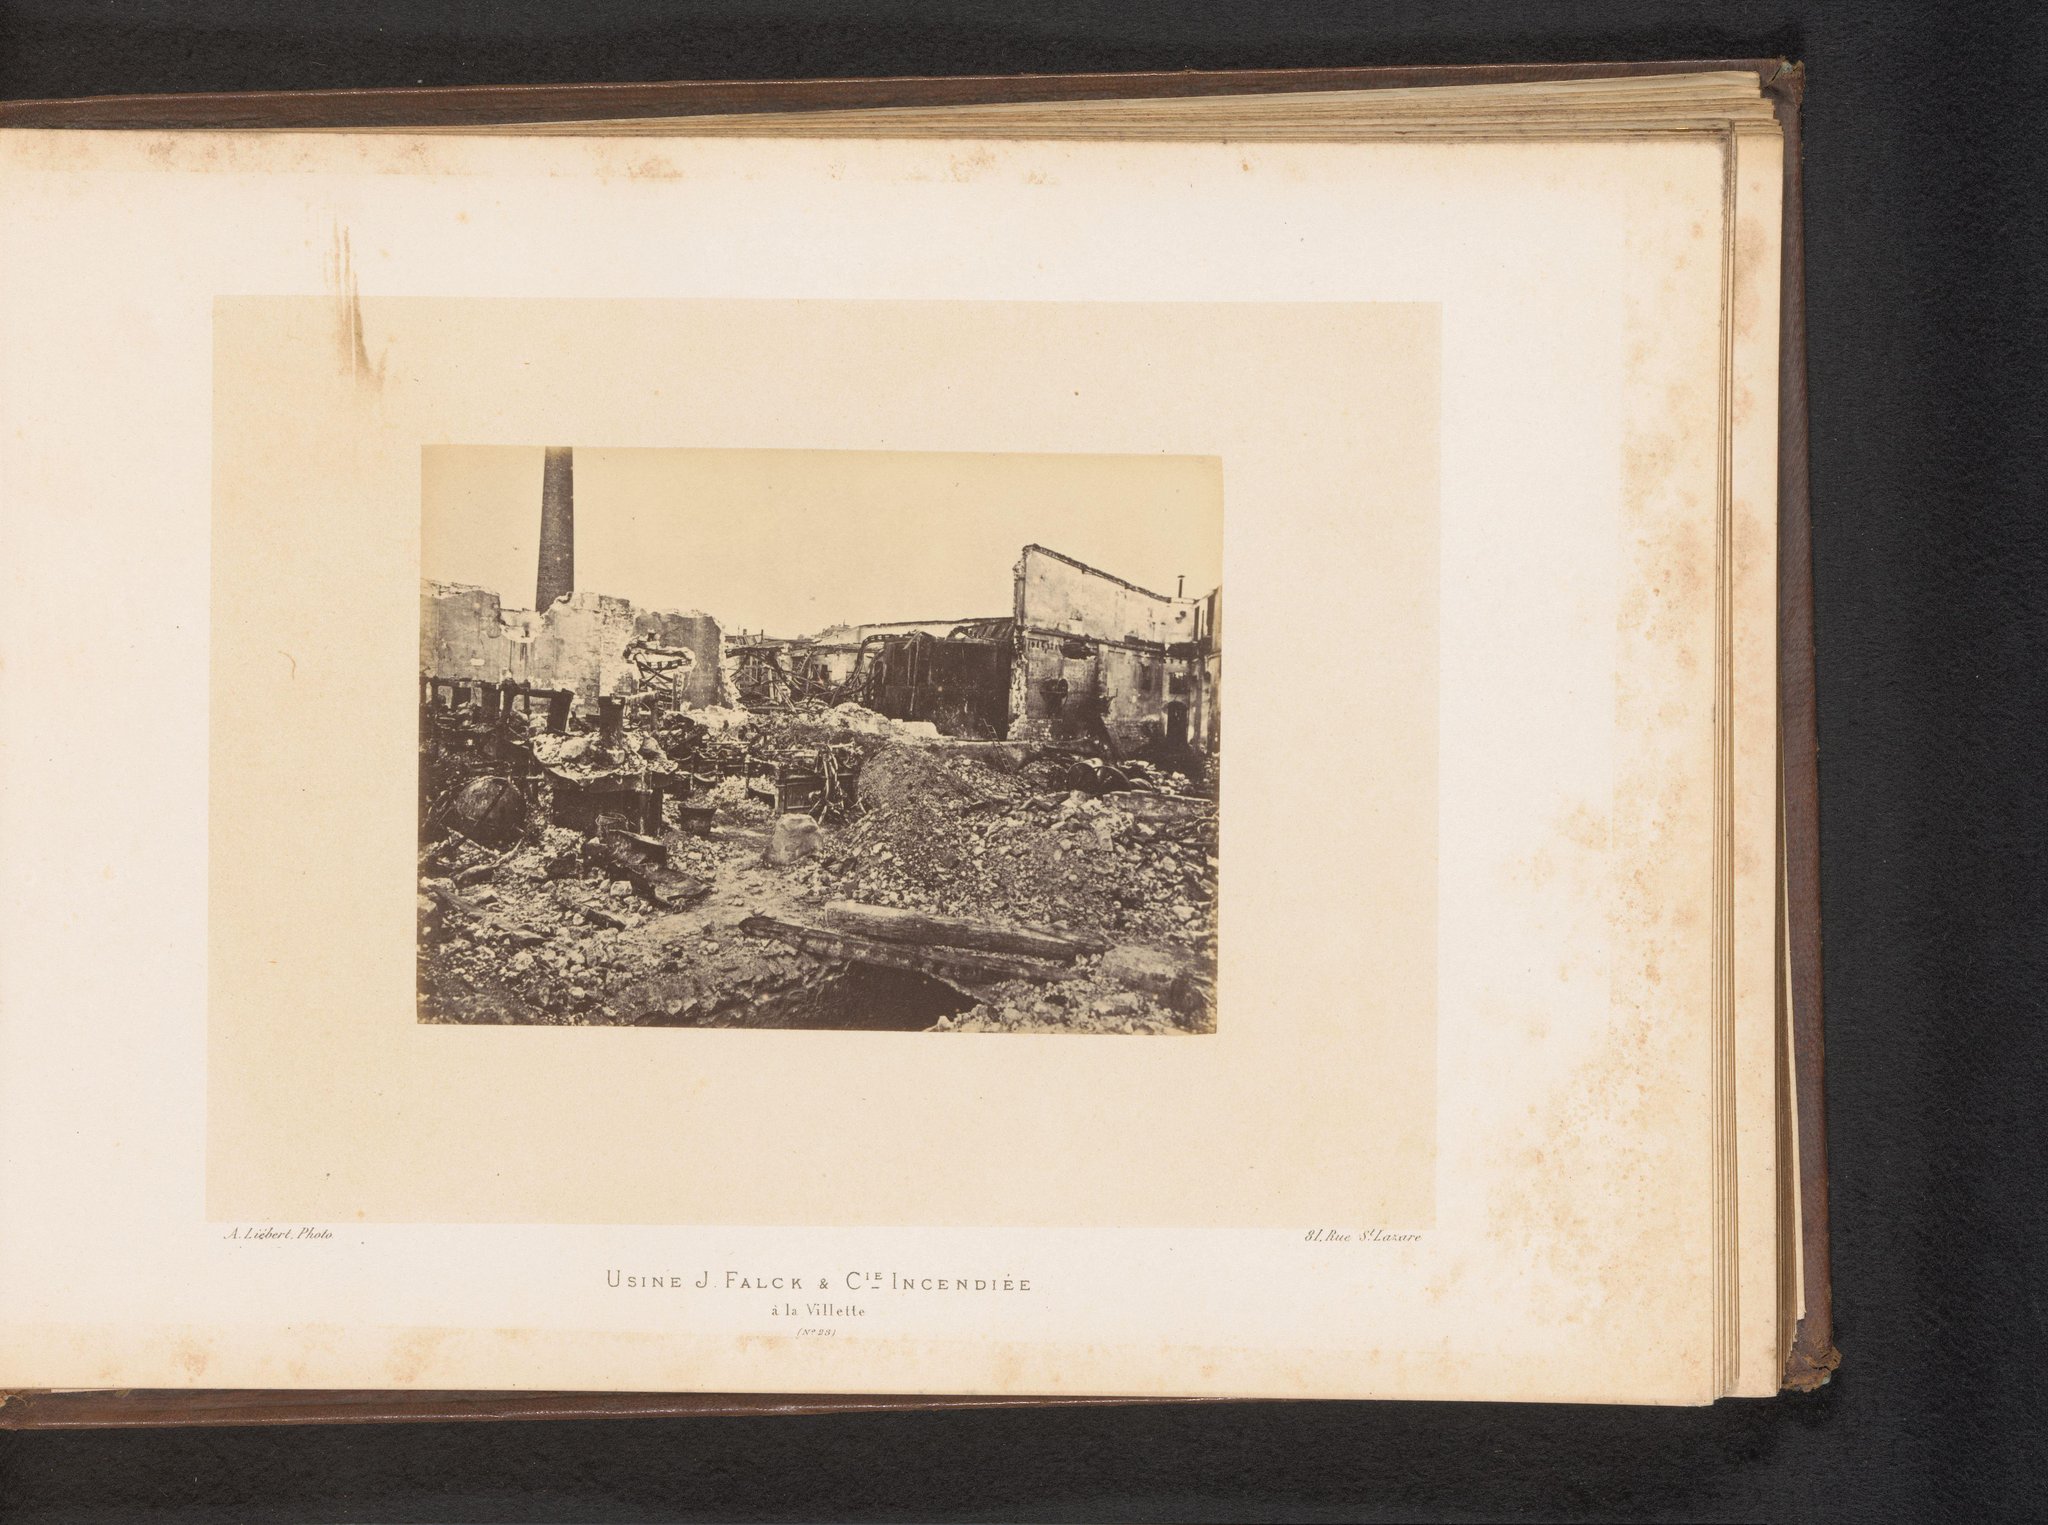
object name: page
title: Usine J. Falck & Cie Incendiée. à la Villette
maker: alphonse-justin liébert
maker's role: fotograaf, marinier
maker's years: 1827-1914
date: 1871-1872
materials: photographic support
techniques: albumen print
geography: paris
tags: factory-building, ruin of a building ~ architecture, paris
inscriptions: number: ‘(No. 28)’, address: ‘31, Rue St. Lazare’